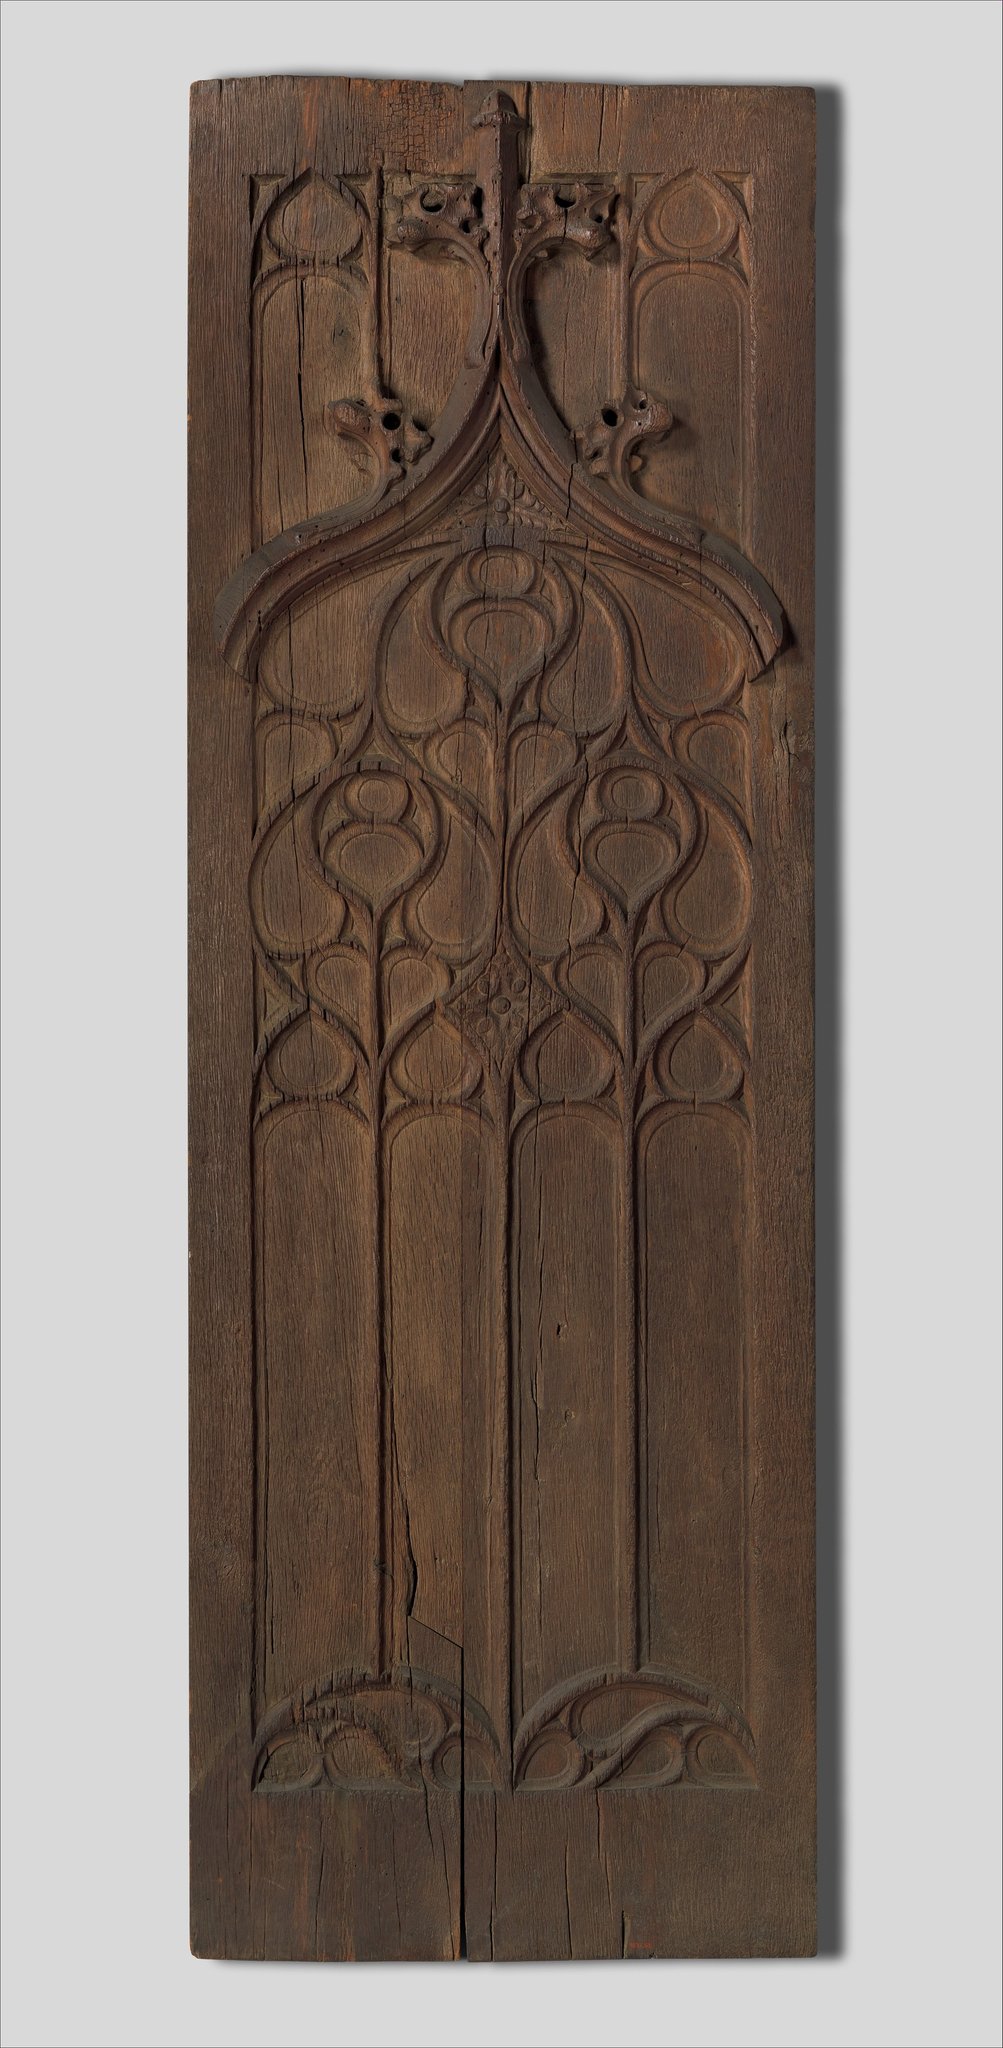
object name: panel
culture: french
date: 1401-1500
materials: wood